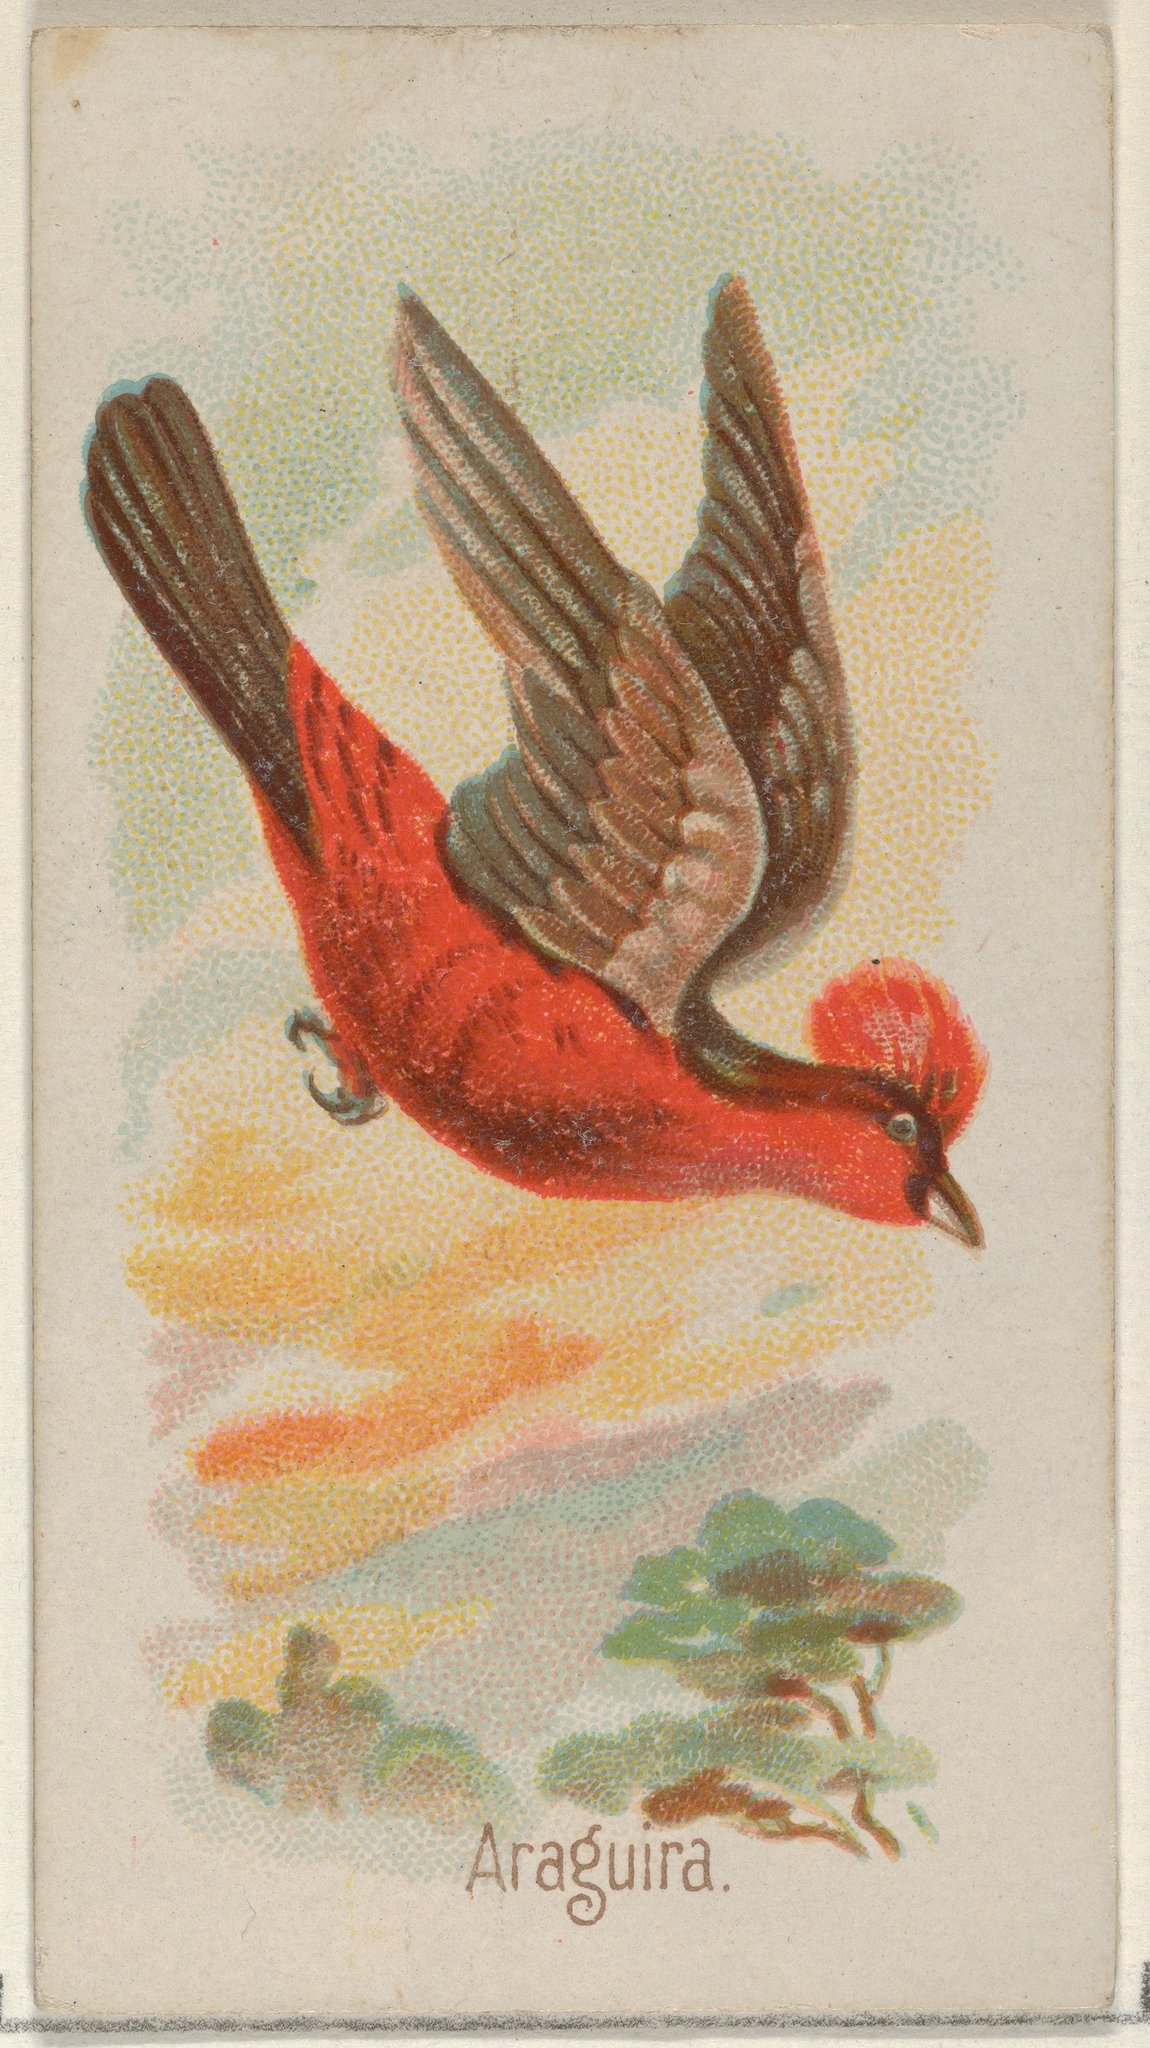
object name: print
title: Araguira, from the Song Birds of the World series (N23) for Allen & Ginter Cigarettes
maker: allen & ginter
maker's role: publisher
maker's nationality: american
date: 1890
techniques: color lithograph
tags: birds